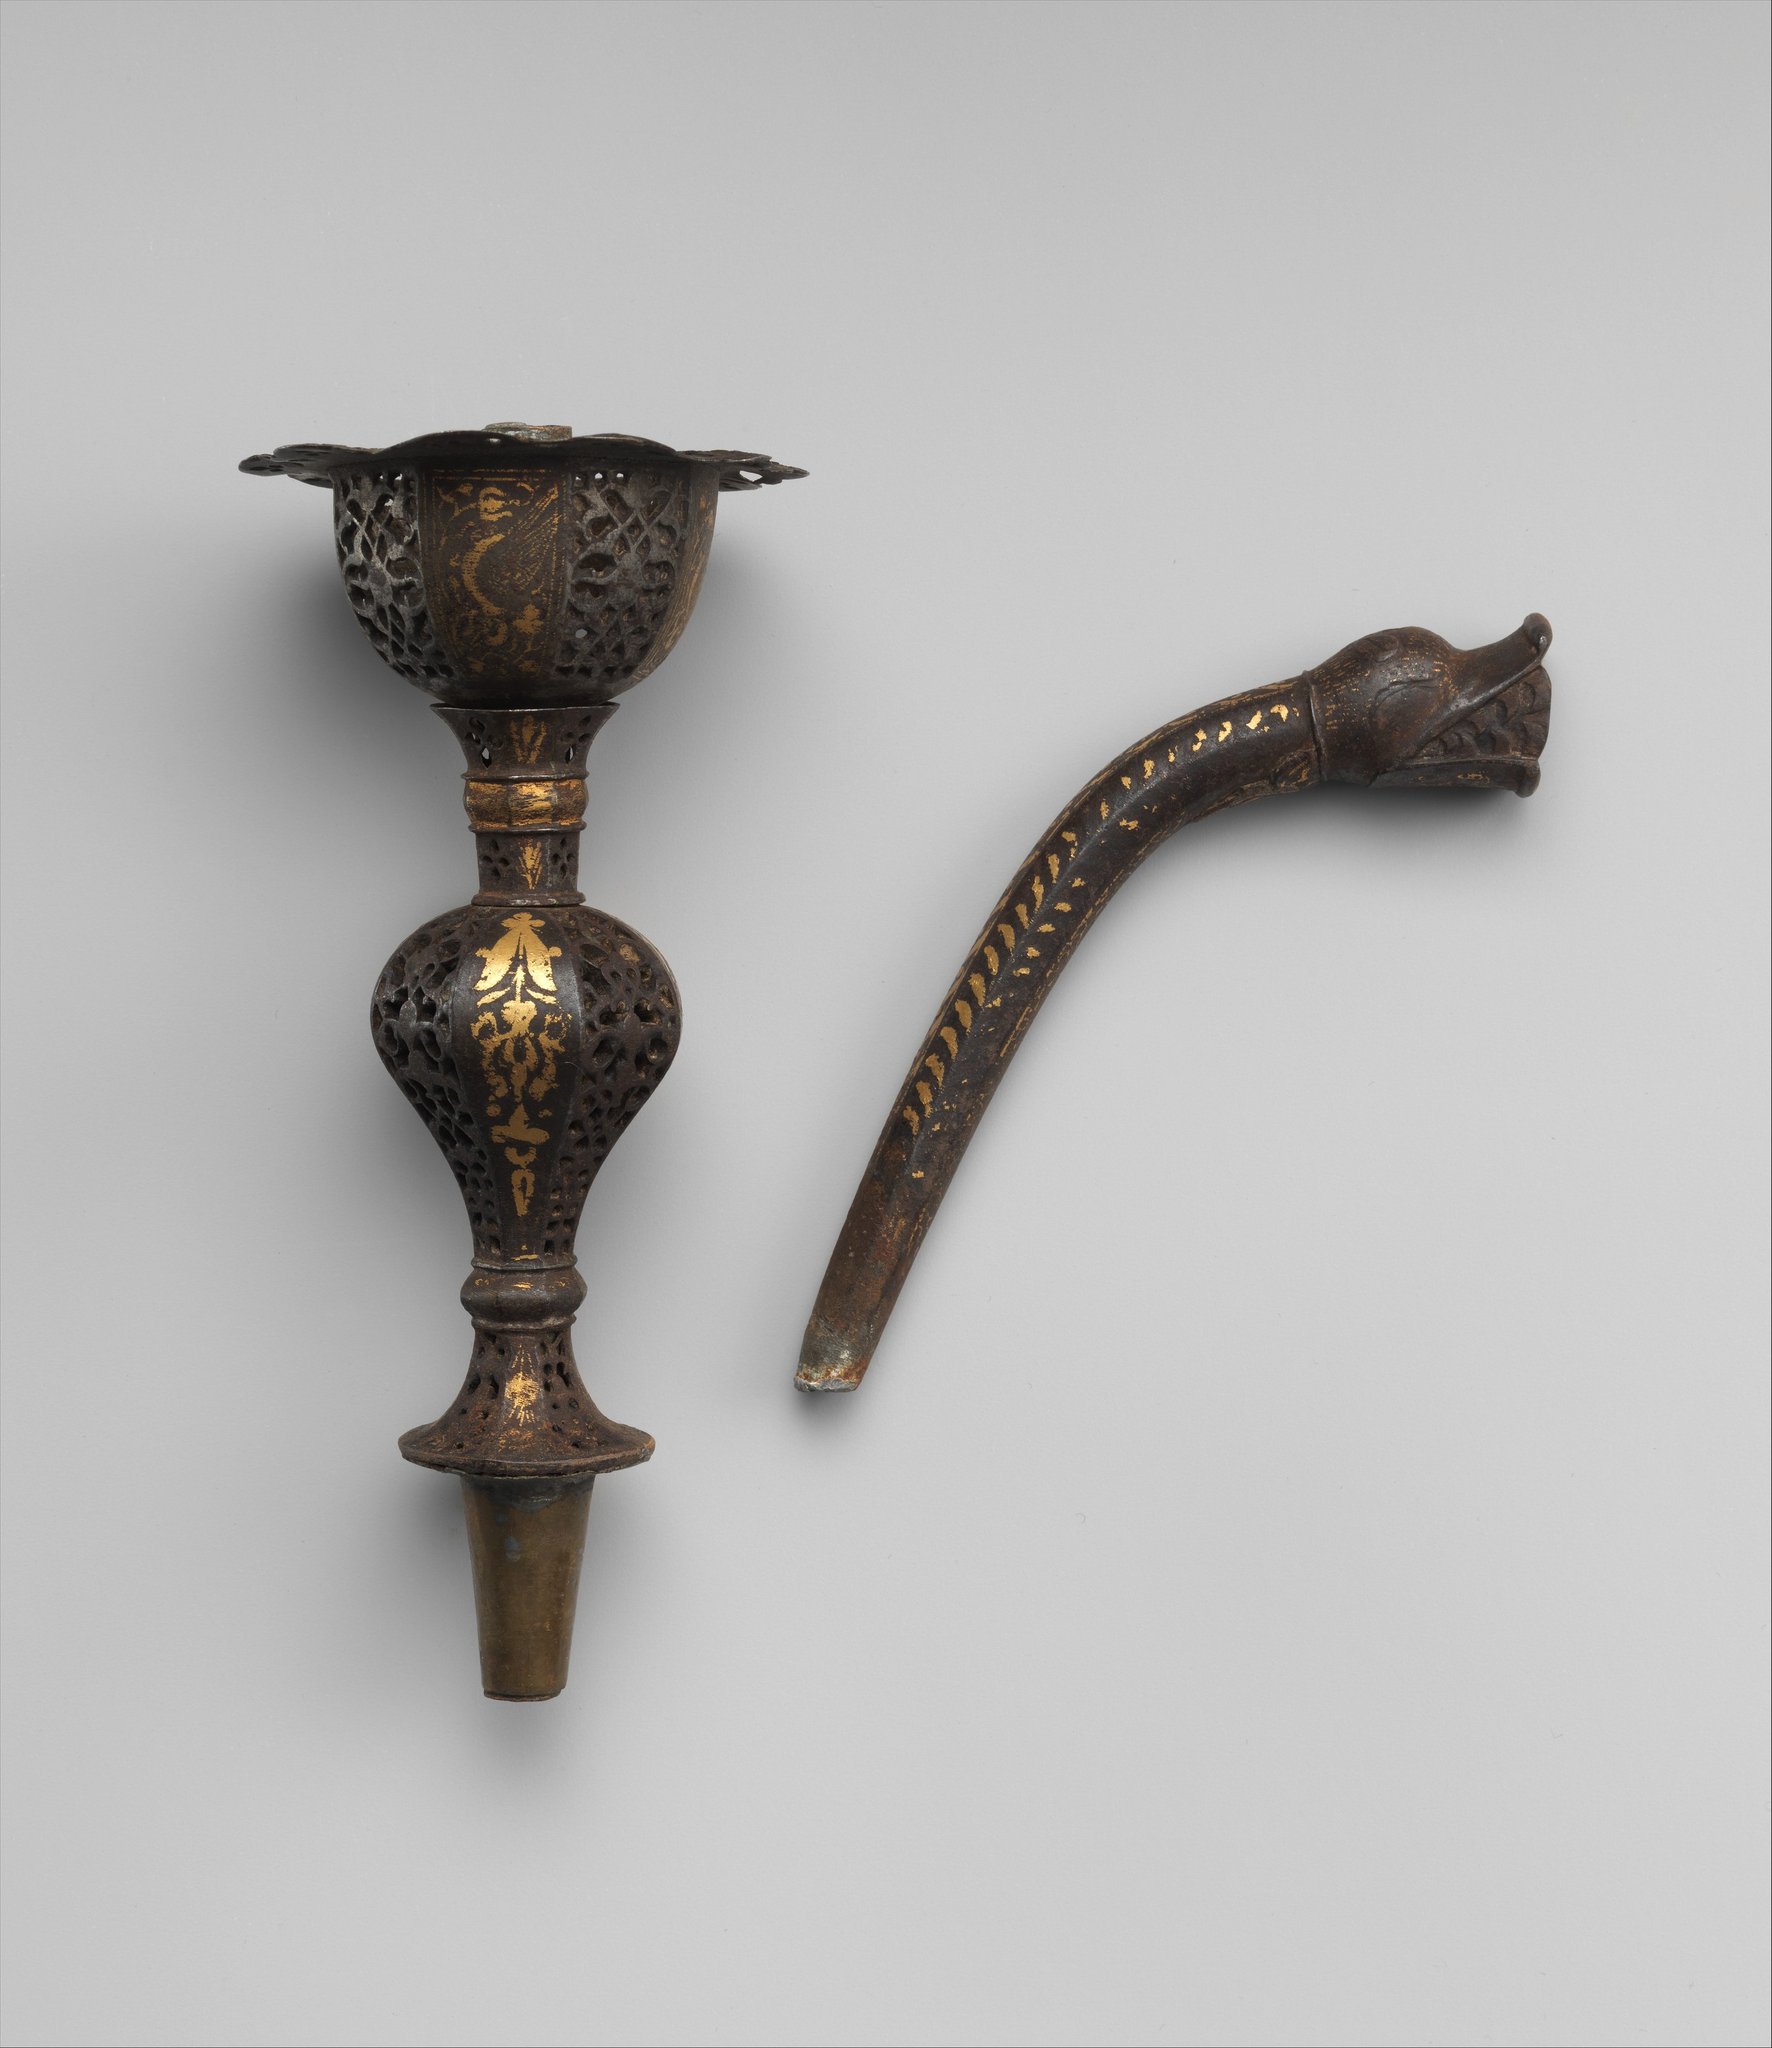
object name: water pipe part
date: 1701-1800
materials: copper alloy, steel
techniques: engraving, gilding, silvered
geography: iran